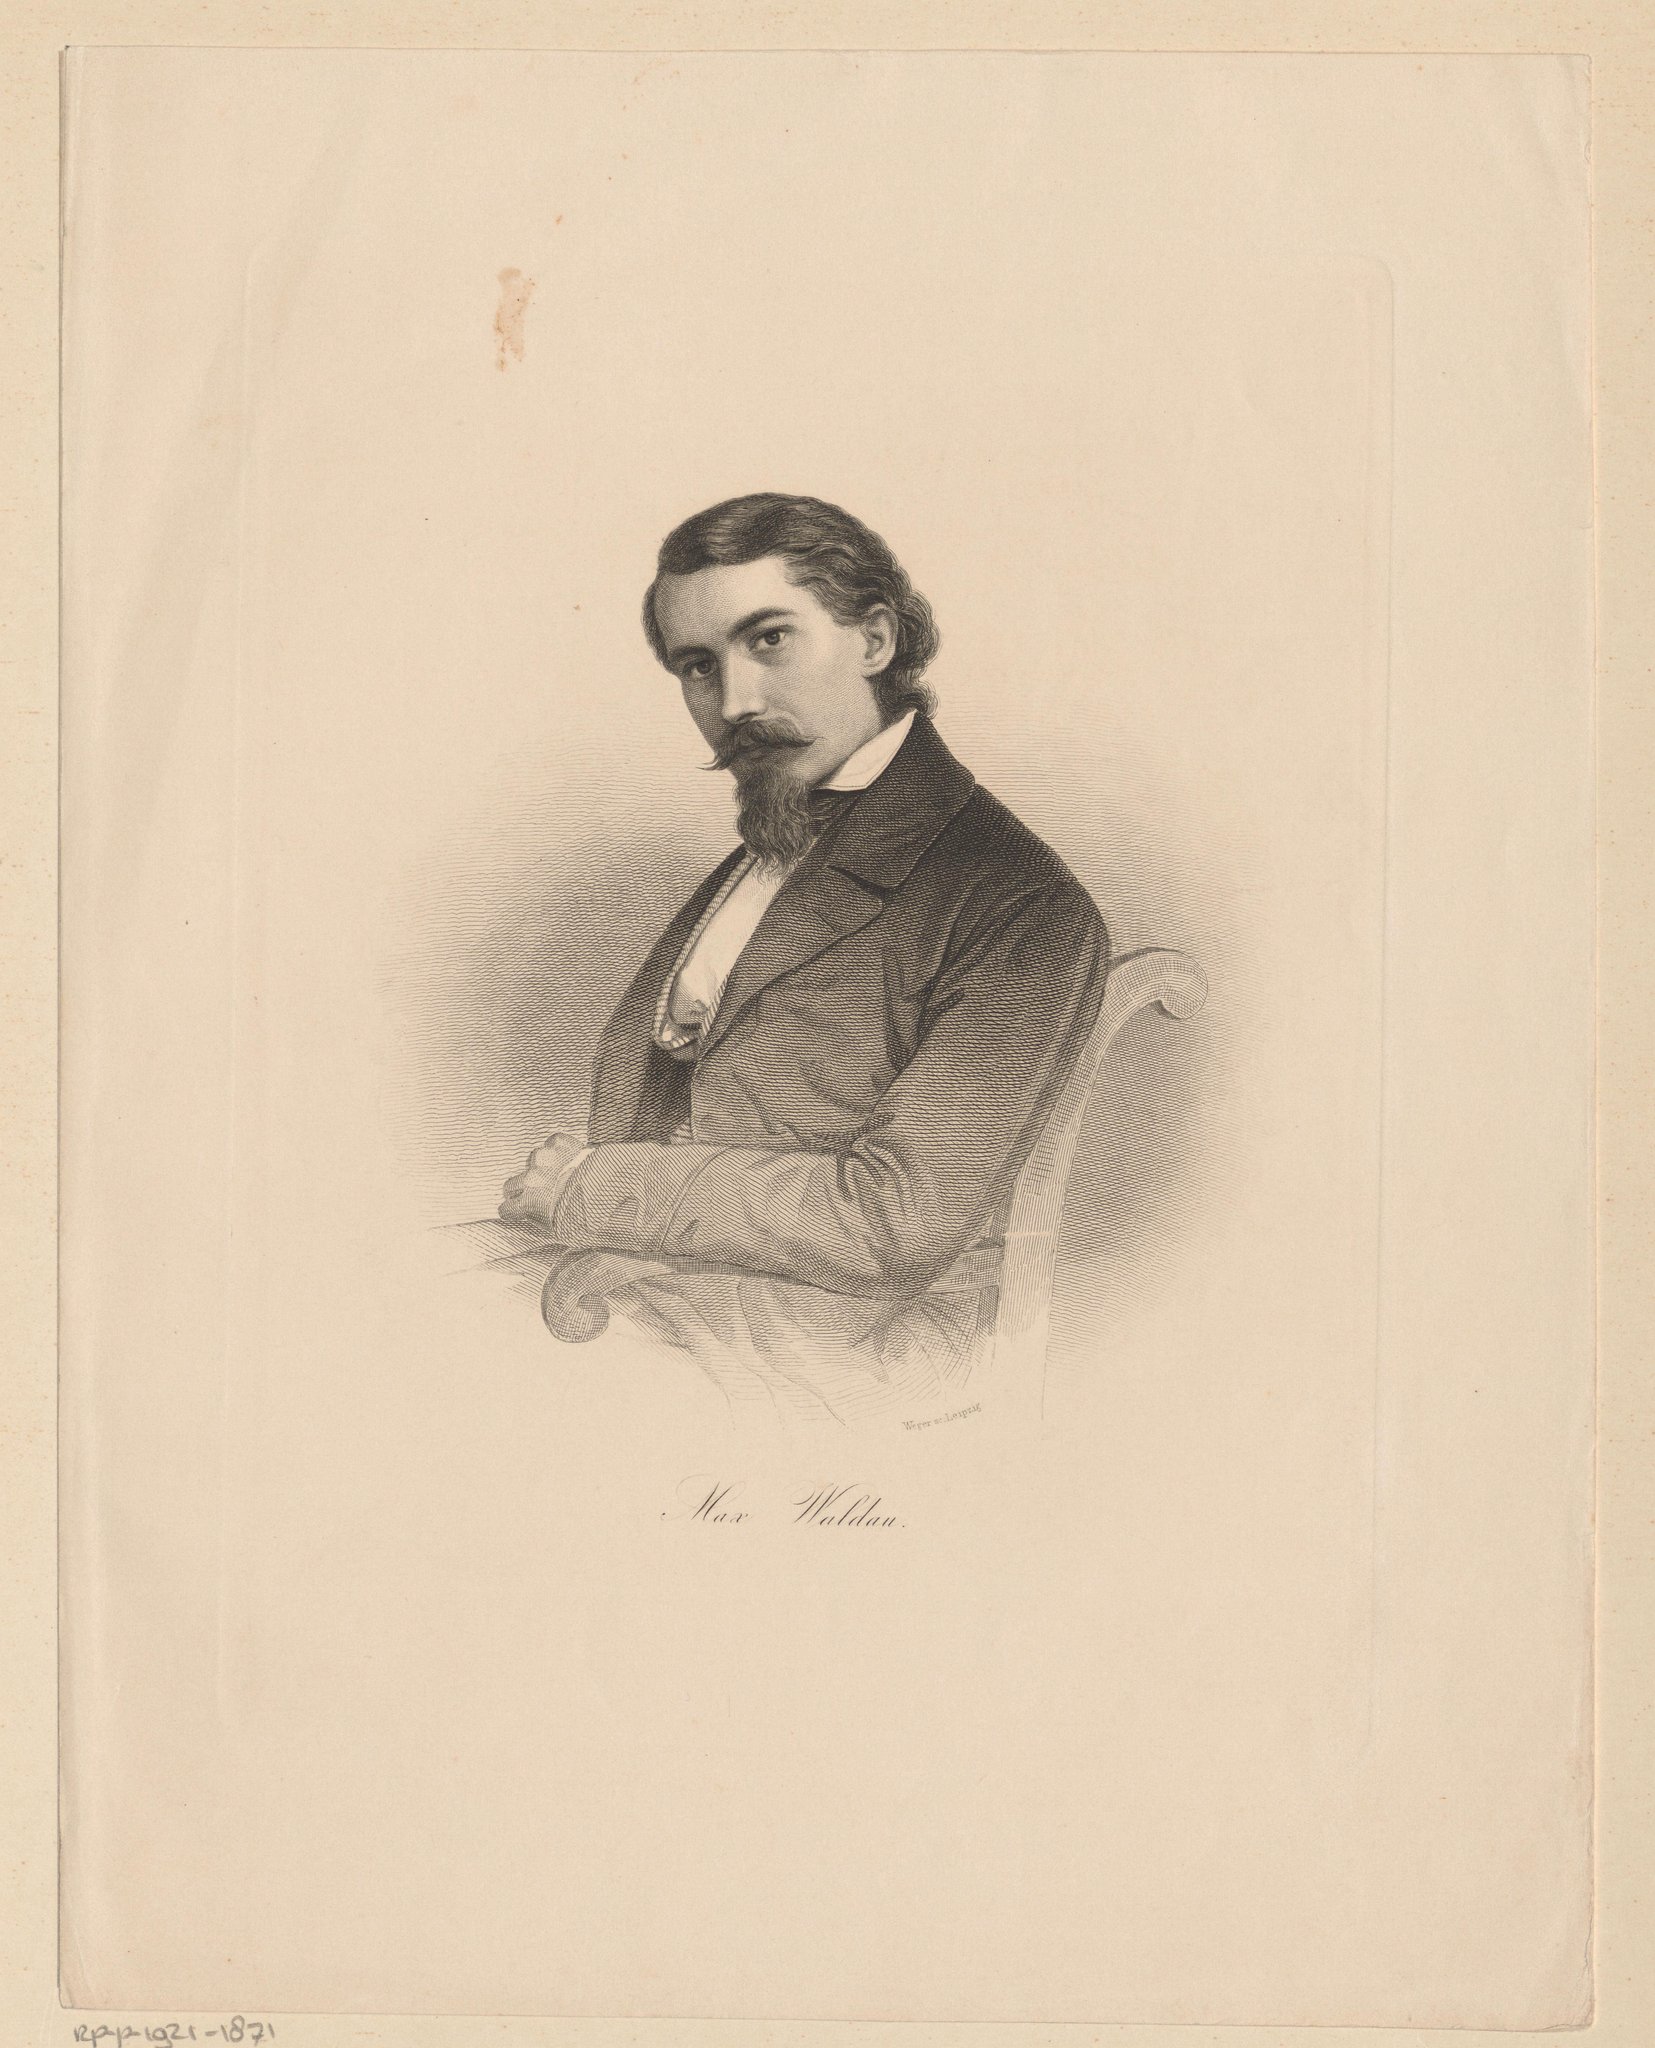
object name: print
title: Portret van Max Waldau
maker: august weger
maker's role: print maker, printer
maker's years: 1823-1892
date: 1847-1892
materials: paper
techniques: engraving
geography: leipzig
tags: poland, historical persons, portrait of a writer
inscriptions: collector's mark: Lugt 2233